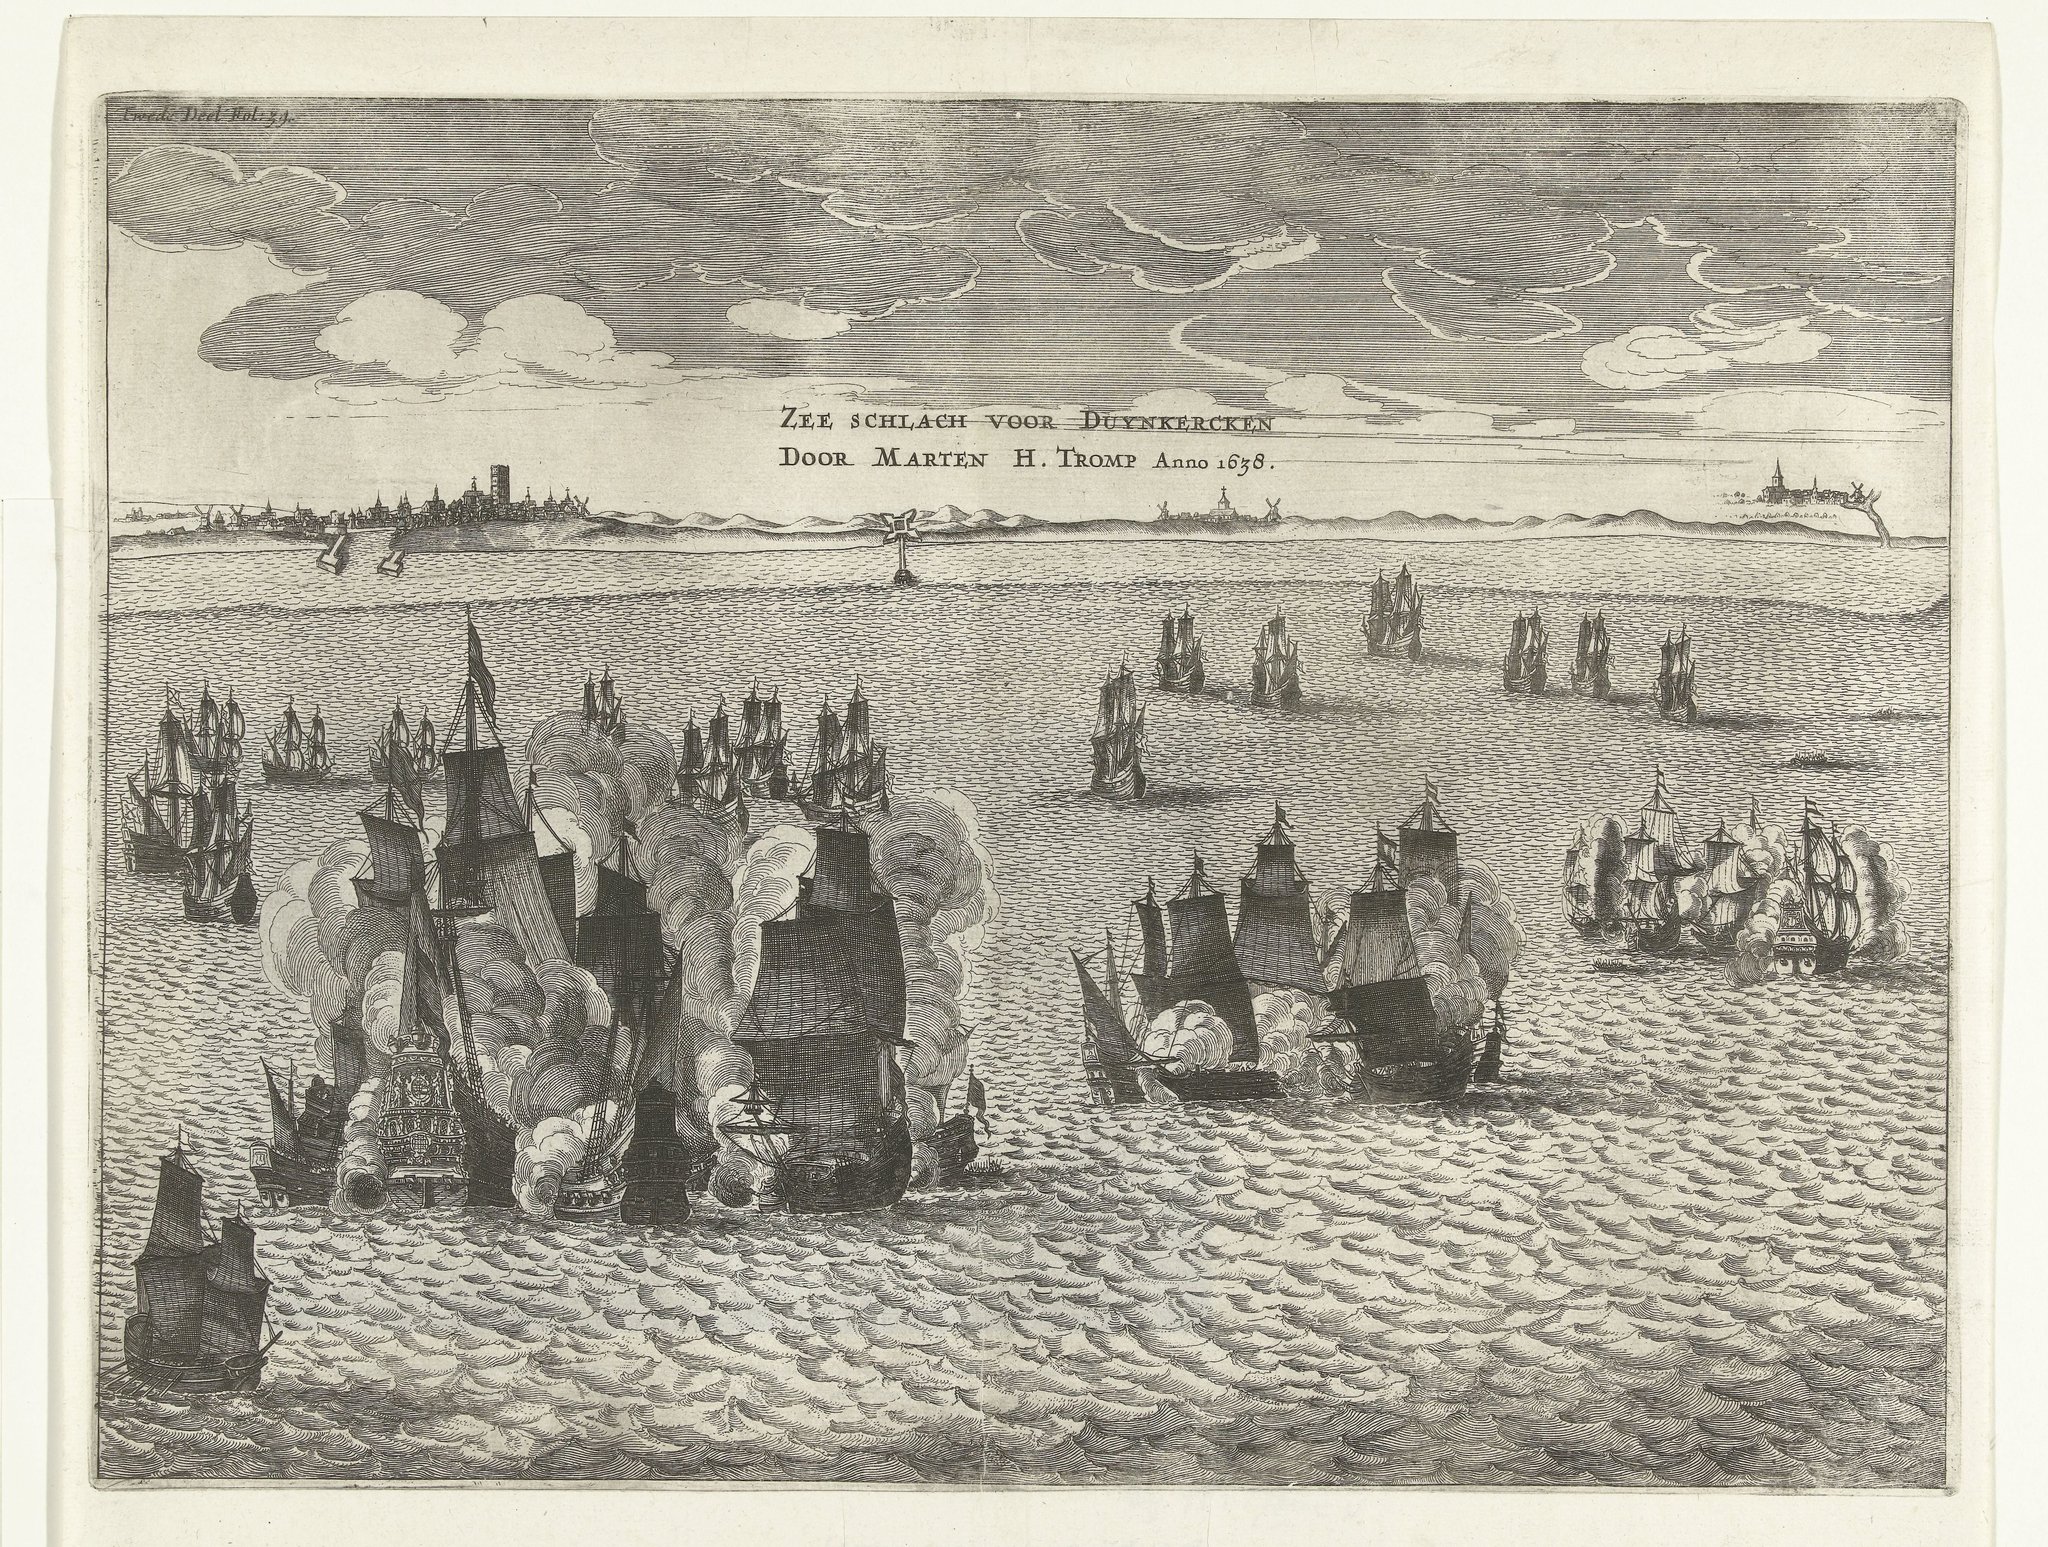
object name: print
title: Zeeslag voor Duinkerken, 1639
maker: Anonymous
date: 1651-1652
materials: paper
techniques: etching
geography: northern netherlands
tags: brielle, maarten harpertszoon tromp, battle (+ naval force)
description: Gebruikt als illustratie in: I. Commelin, Frederick Hendrick van Nassauw prince van Orangien zyn leven en bedryf, Wed. Esdras Willemsz Snellaert en Gerrit Nieuwenhuysen, Utrecht 1652, dl. 2, fol. 34. Spiegelbeeldige kopie naar de prent in de uitgave van Jodocus Janssonius van 1651 (FMH 1796a).